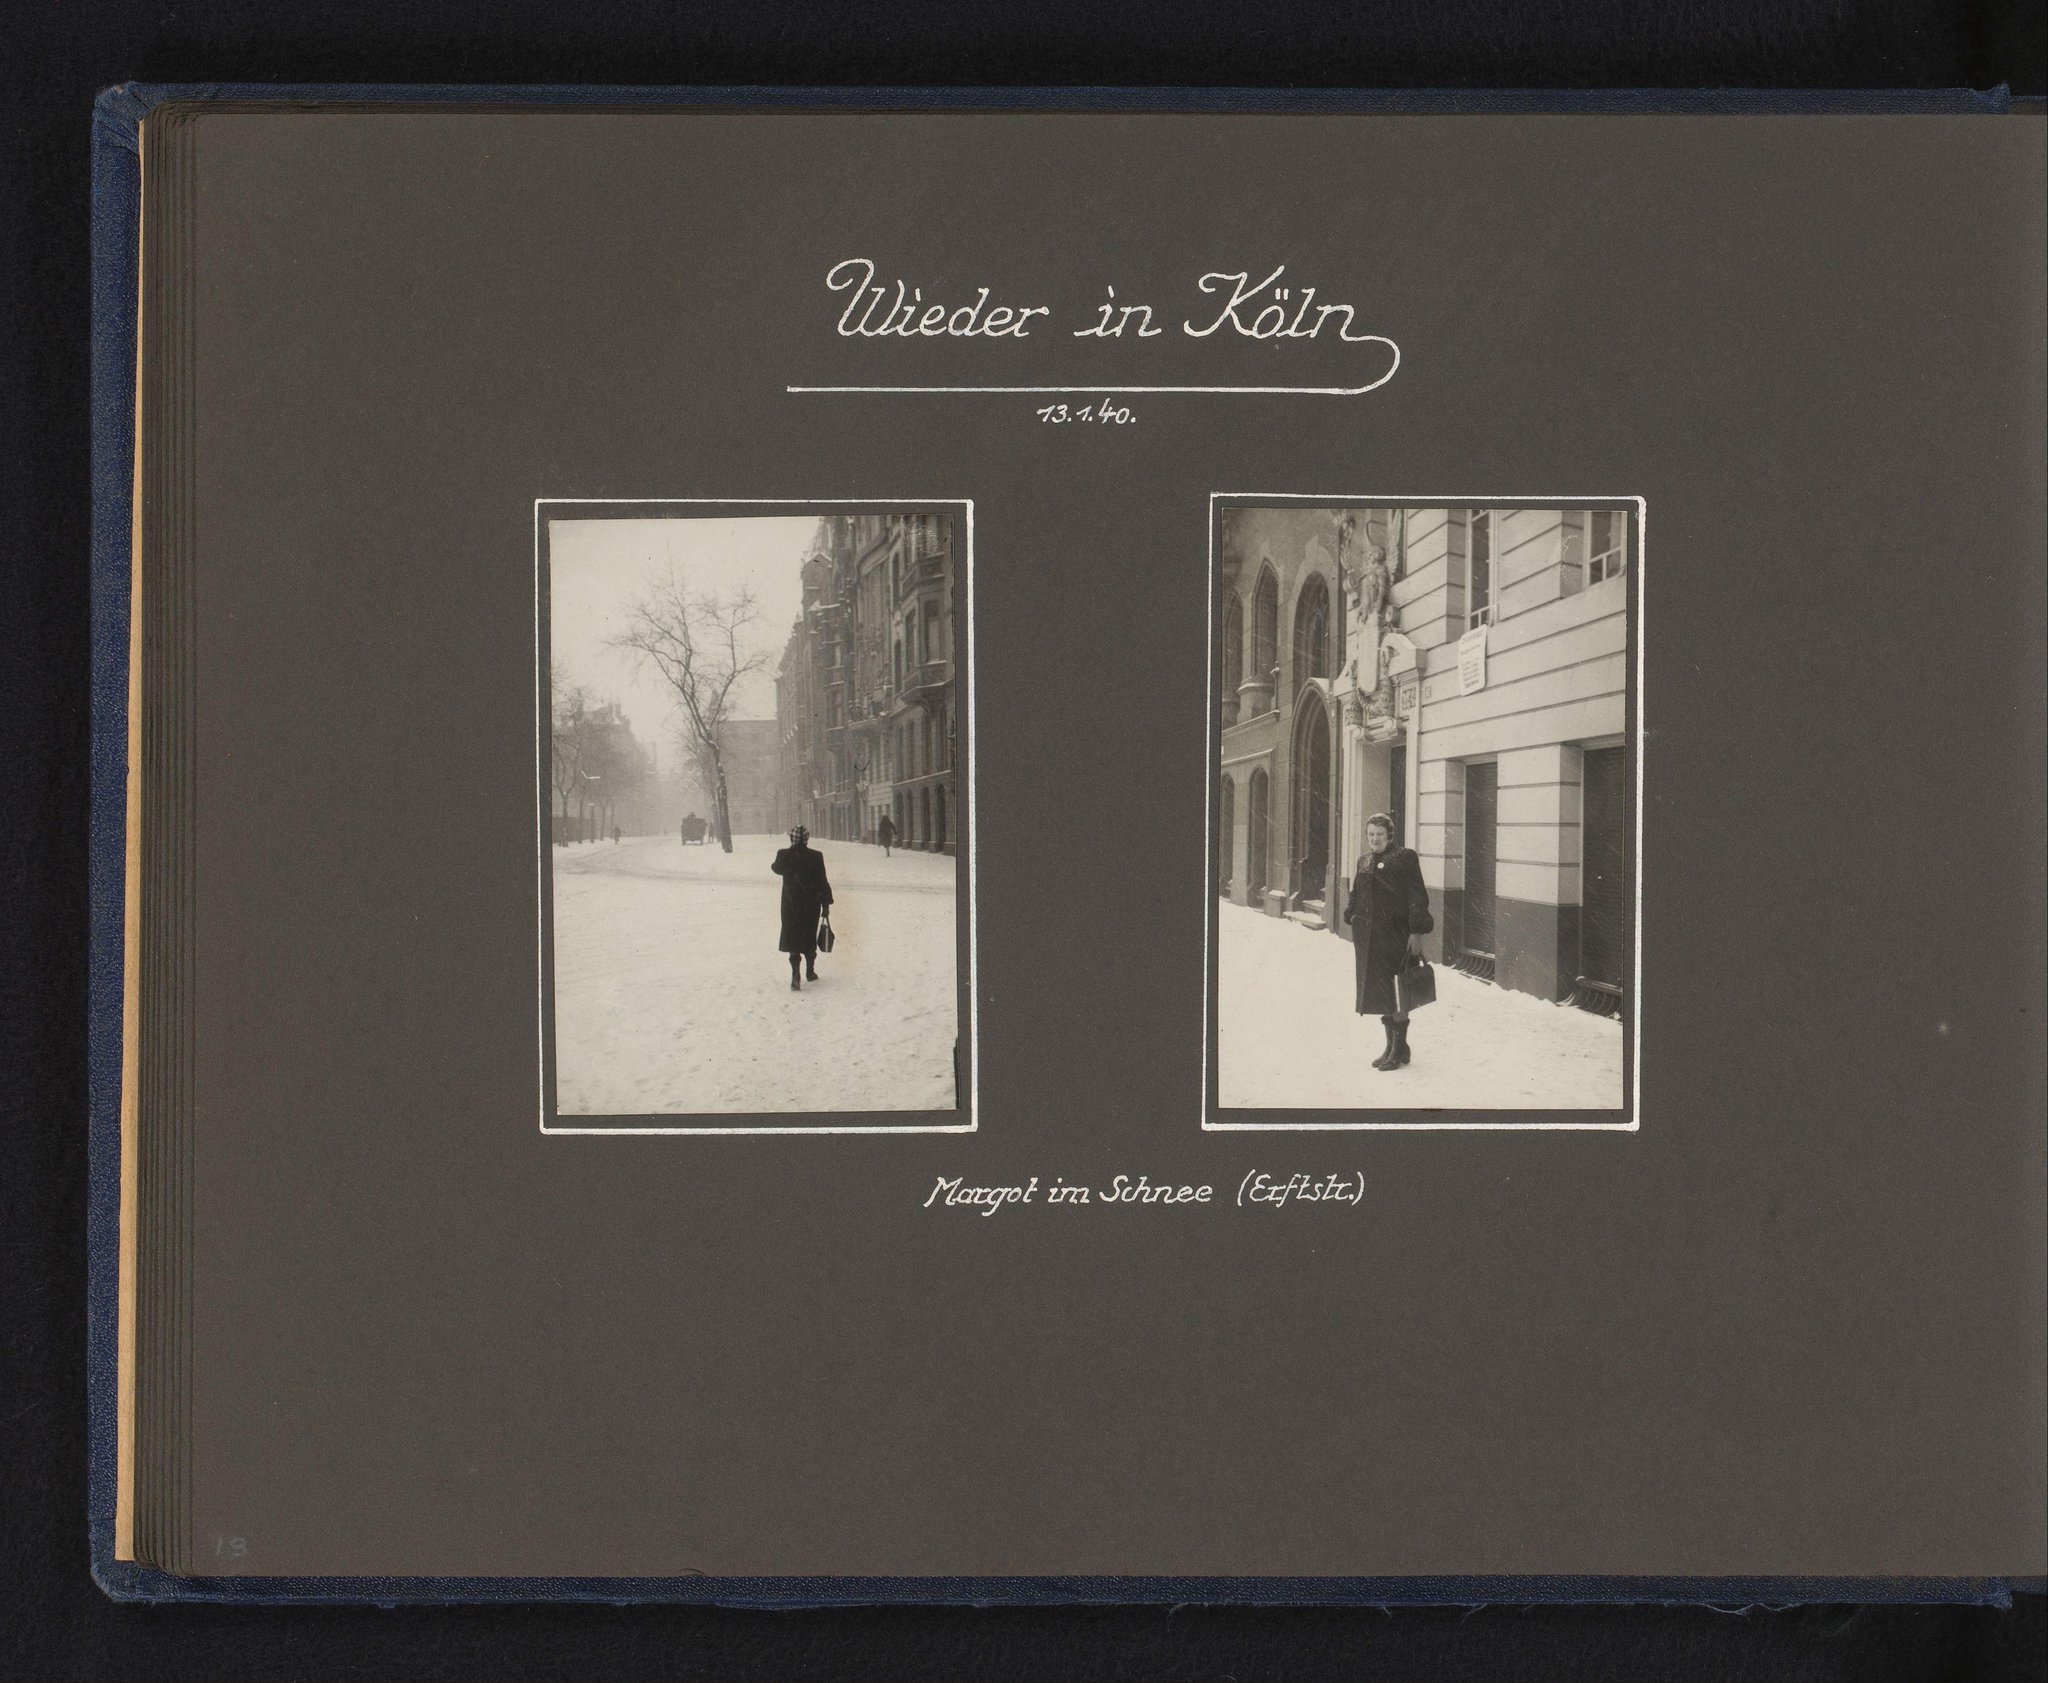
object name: album leaf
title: Keulen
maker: Anonymous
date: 1940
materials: paper, photographic support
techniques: gelatin silver print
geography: cologne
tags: leave ~ the soldier off duty, germany, cologne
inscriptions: inscription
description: Albumblad met twee foto's in Keulen, januari 1940, van een vrouw 'Margot' op straat in de sneeuw. Onderdeel van een Duits militair album Tweede Wereldoorlog 1939-1940.